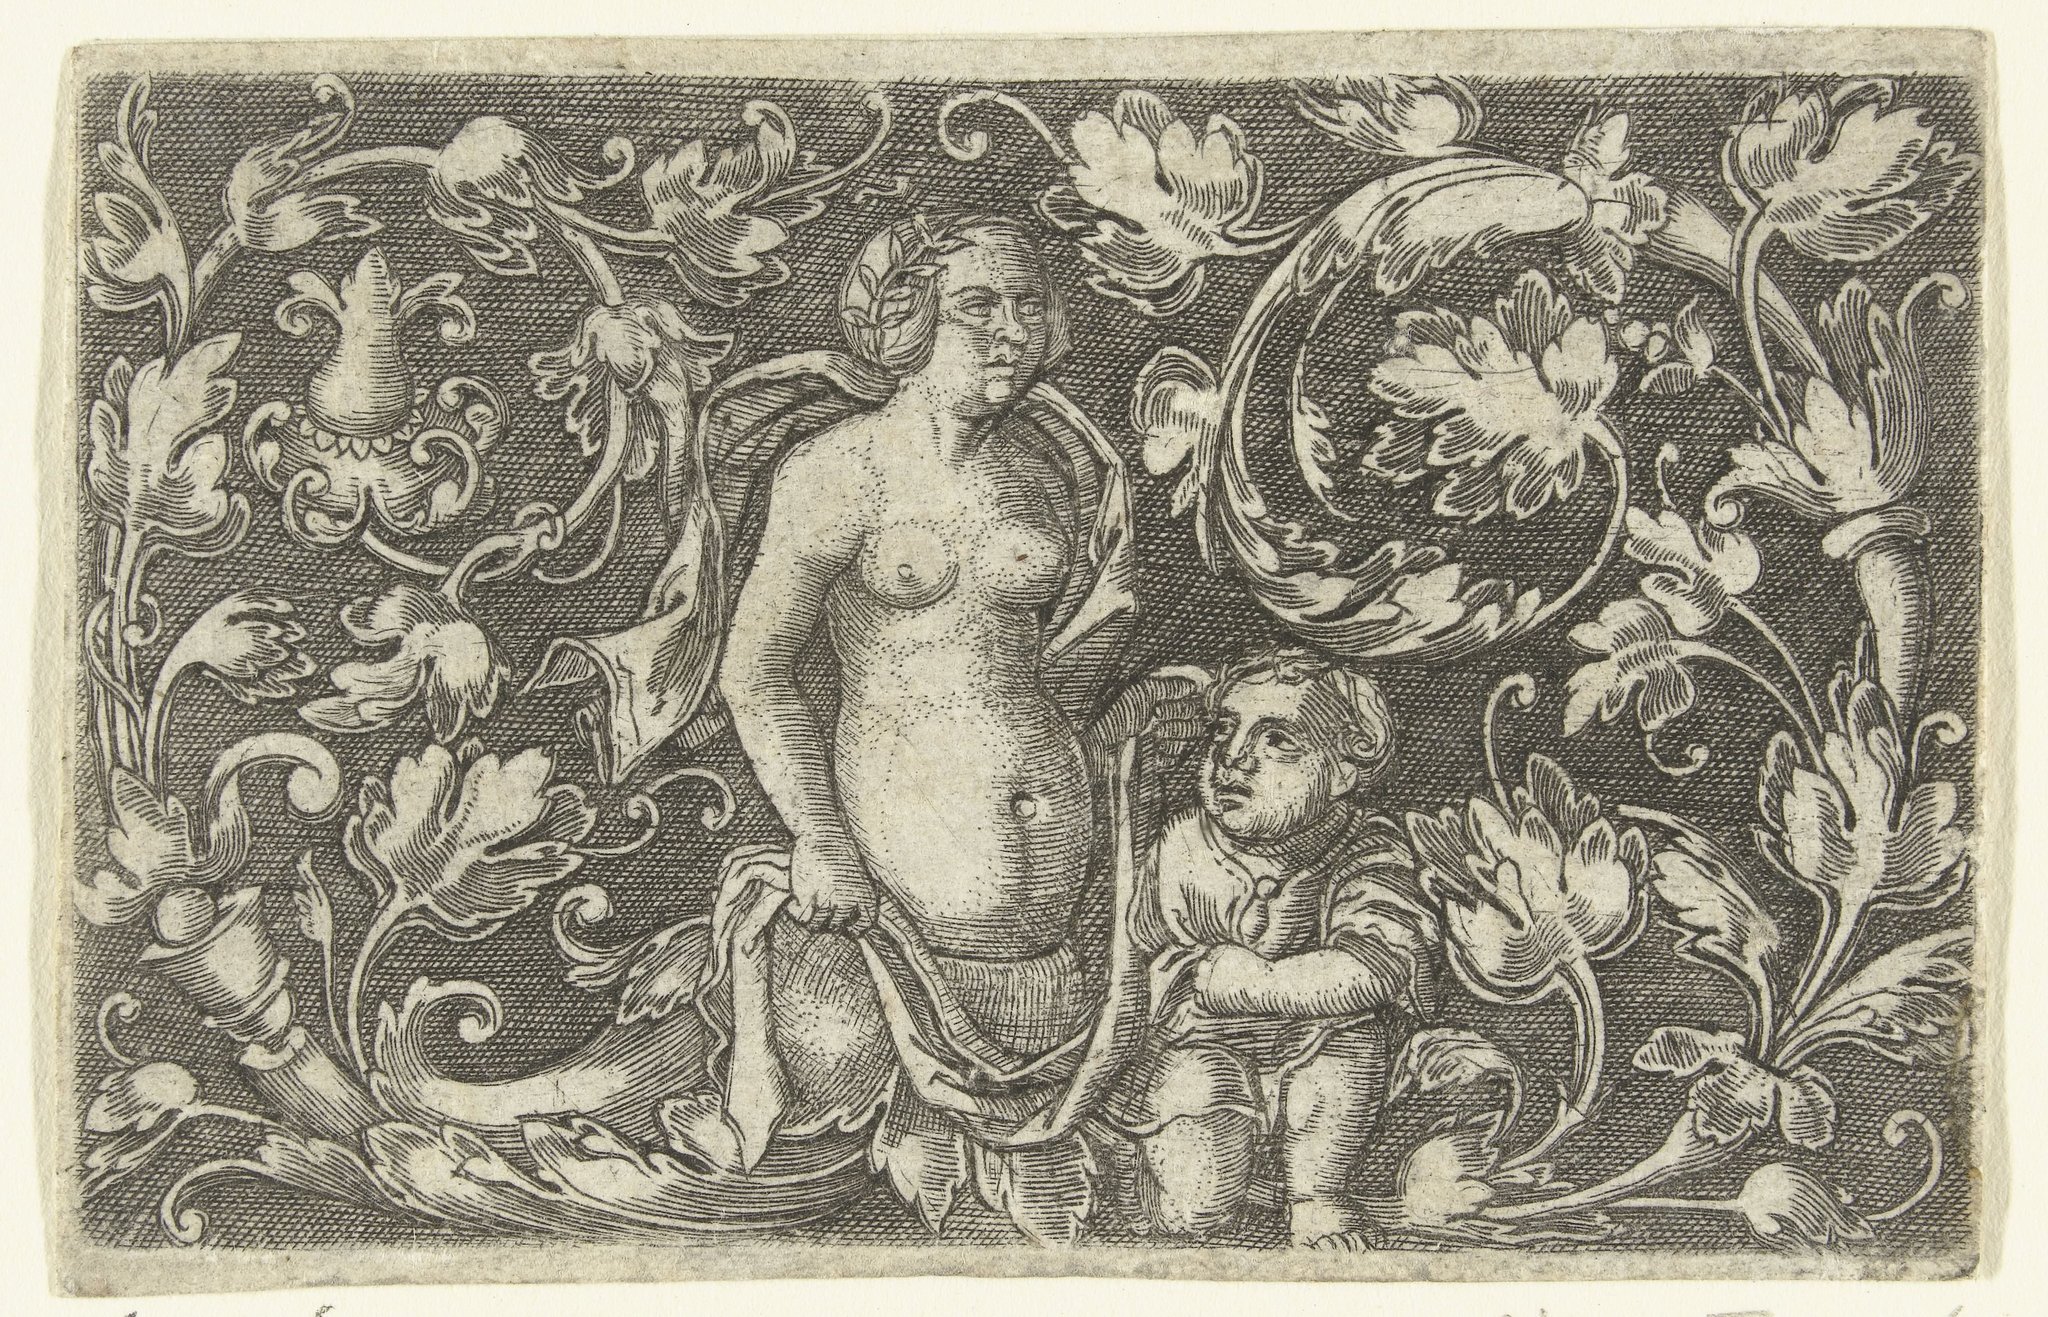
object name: print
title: Naakt bovenlichaam van een vrouw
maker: Anonymous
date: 1500-1600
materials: paper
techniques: engraving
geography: germany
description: Vlakdecoratie. Het bovenlichaam van de vrouw loopt uit in een voluut met bladranken en bloemen. Naast de vrouw knielt een kind.